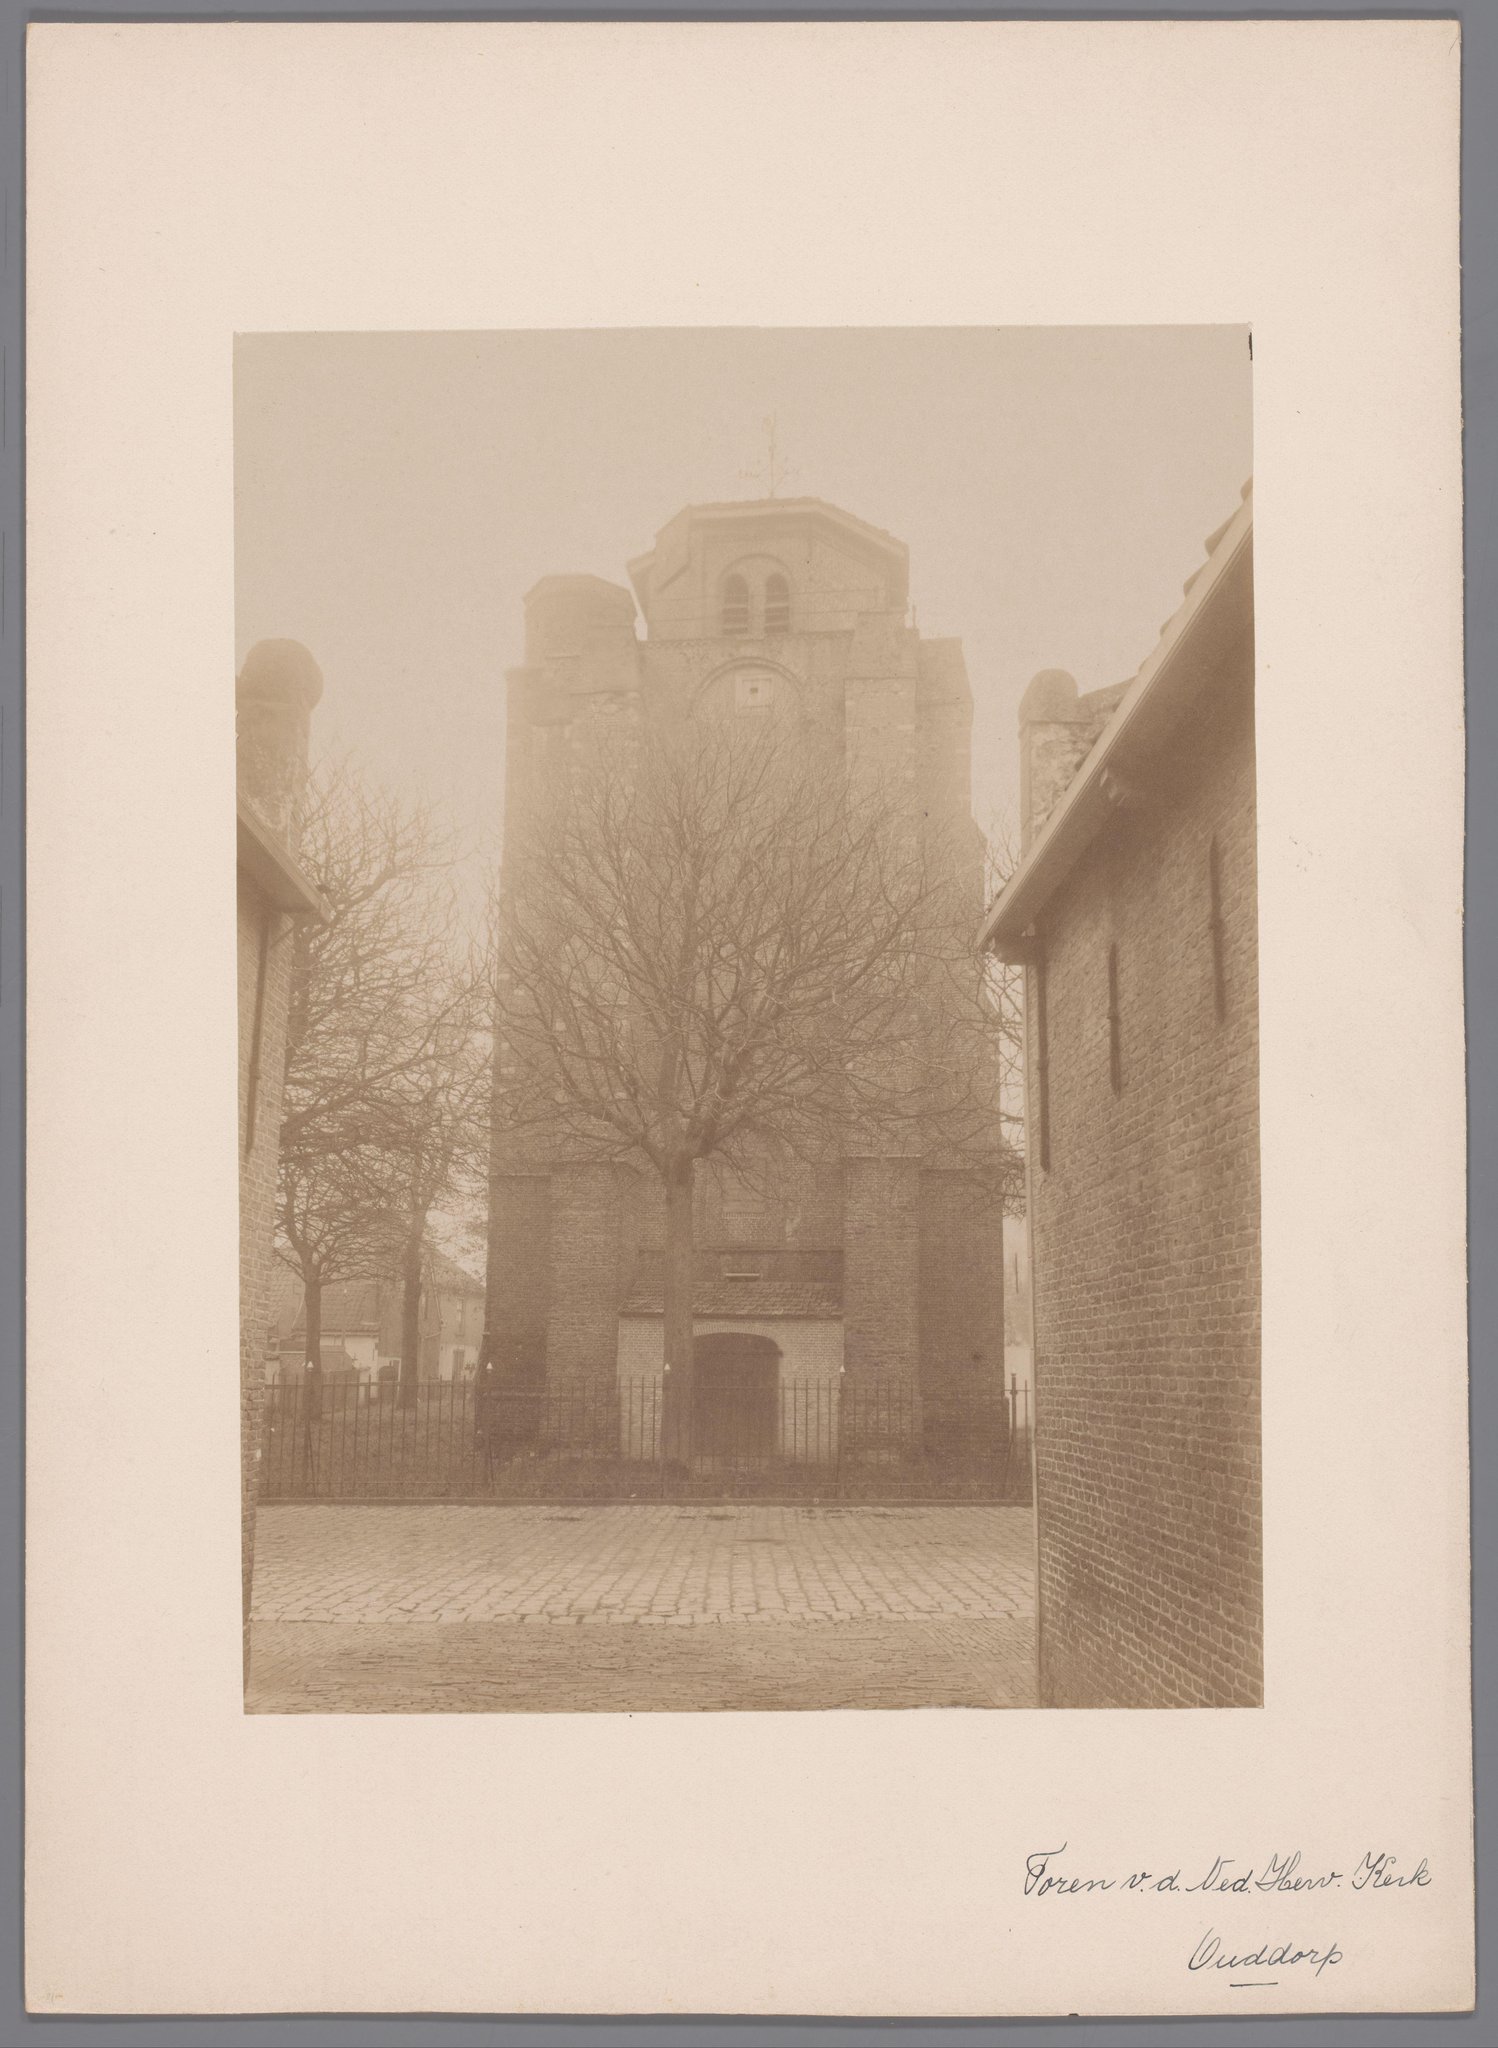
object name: photograph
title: Toren van de Dorpskerk te Ouddorp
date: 1902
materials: cardboard, photographic support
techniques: albumen print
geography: ouddorp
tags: church (exterior), tower (of house or building)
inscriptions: annotation: ‘Toren v.d. Ned. Herv. Kerk/ Ouddorp’, annotation: ‘Ouddorp (N.H.)/ Toren v/d Ned Herv. Kerk/ Nov 1902’